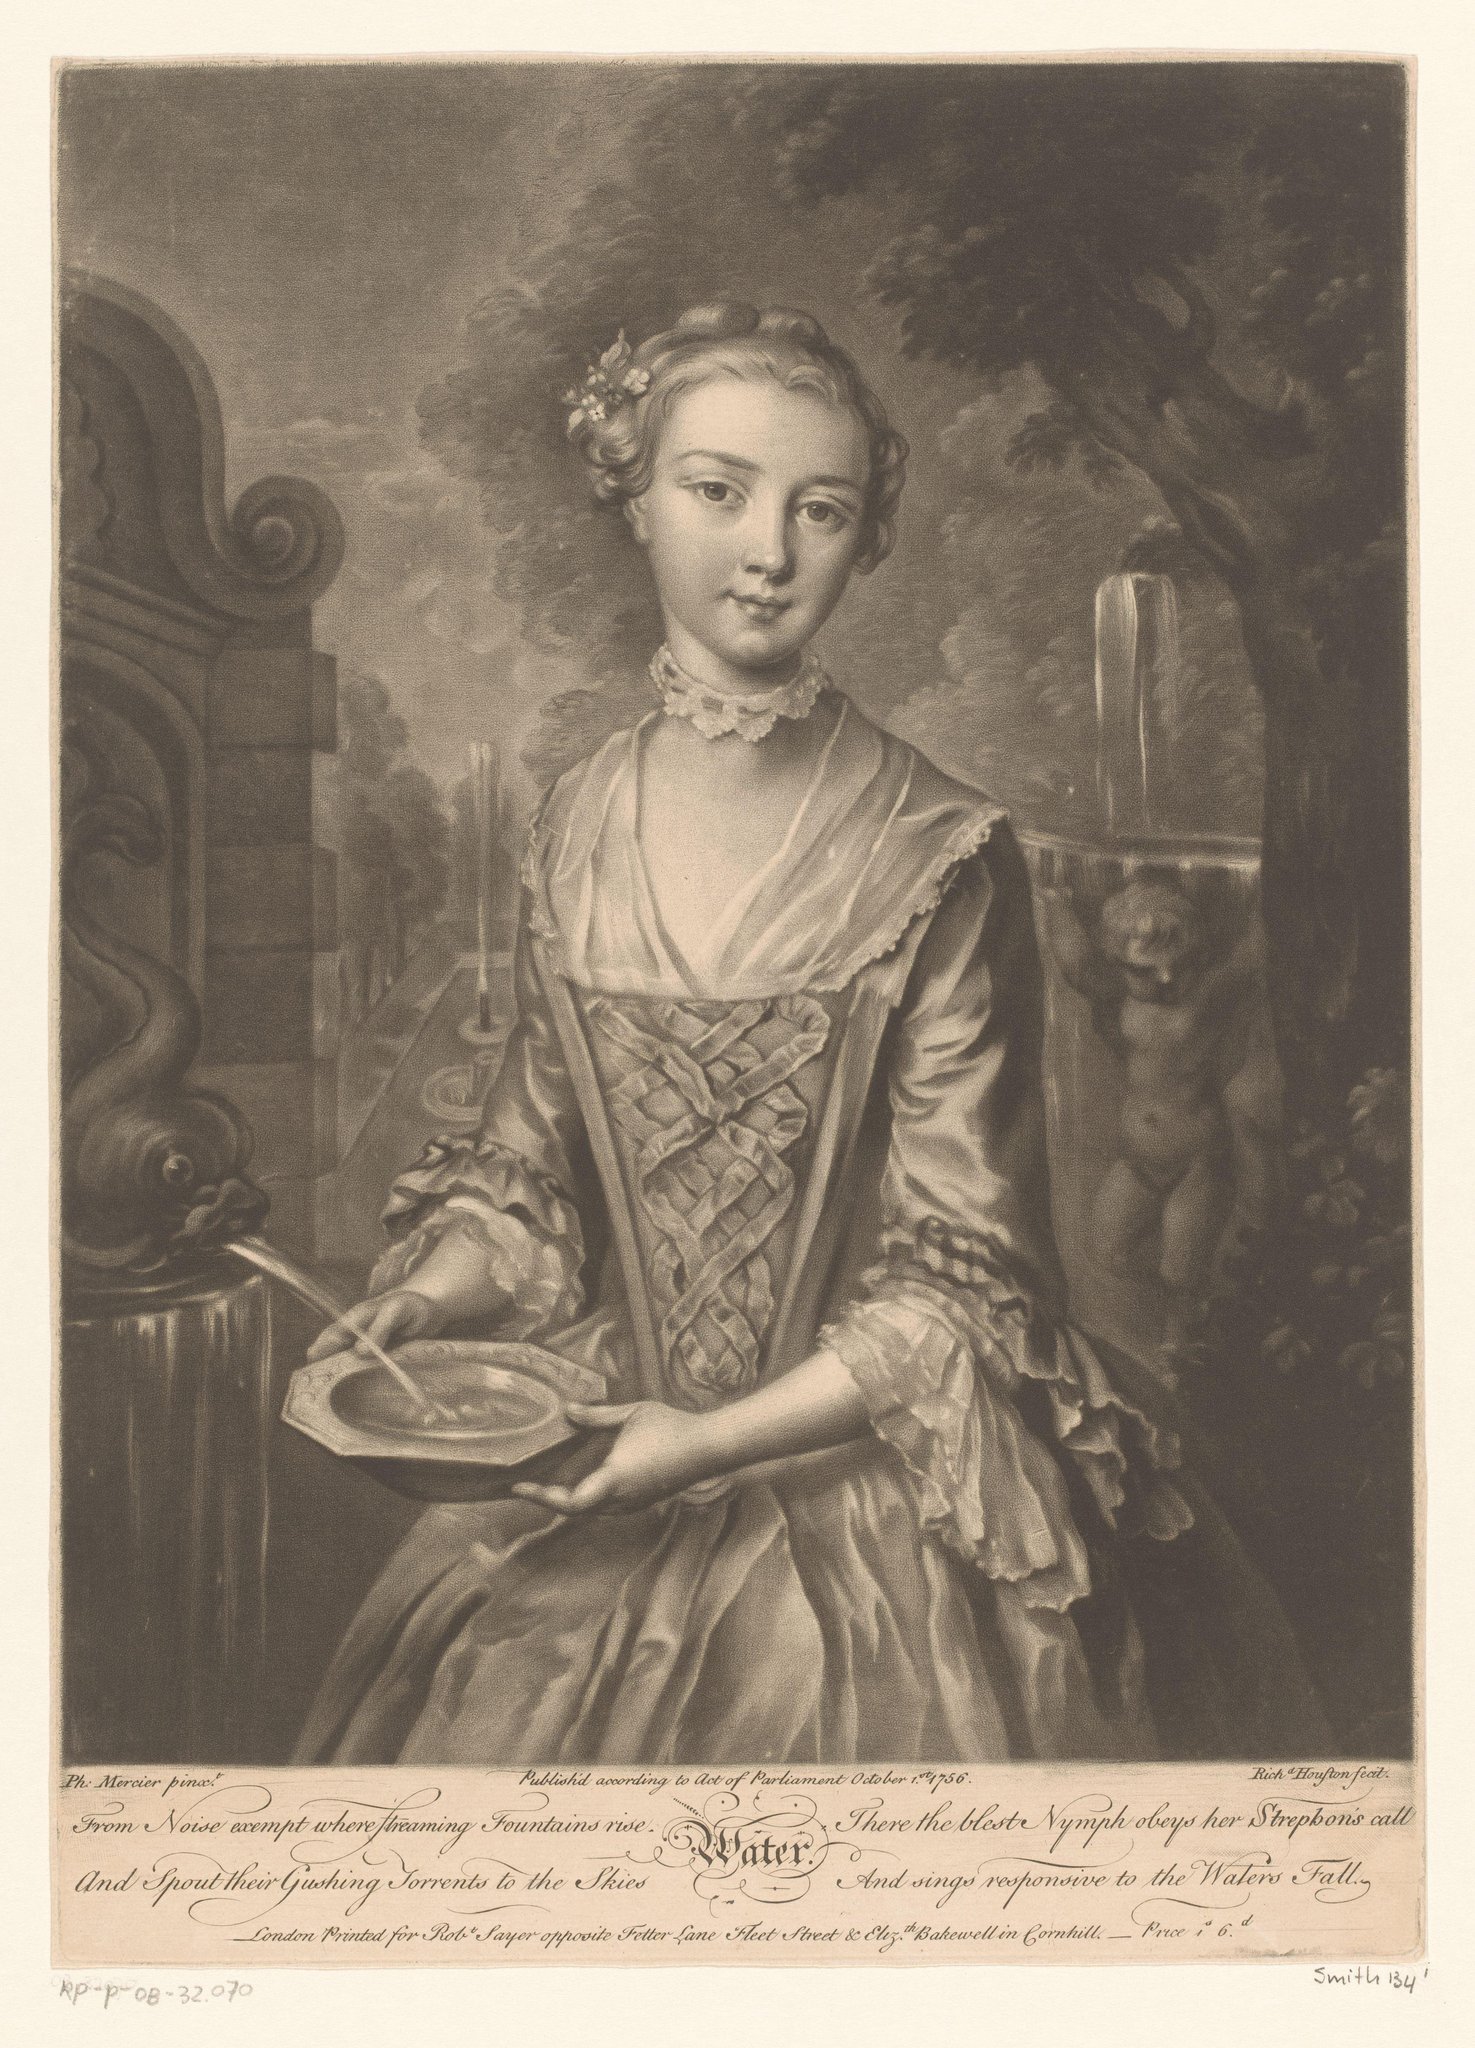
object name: print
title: Jonge vrouw bij een bron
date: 1756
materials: paper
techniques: mezzotint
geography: london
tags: well, 10-20 years, water (one of the four elements)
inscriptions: collector's mark: Lugt 240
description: Deze prent maakt deel uit van een serie van vier prenten.